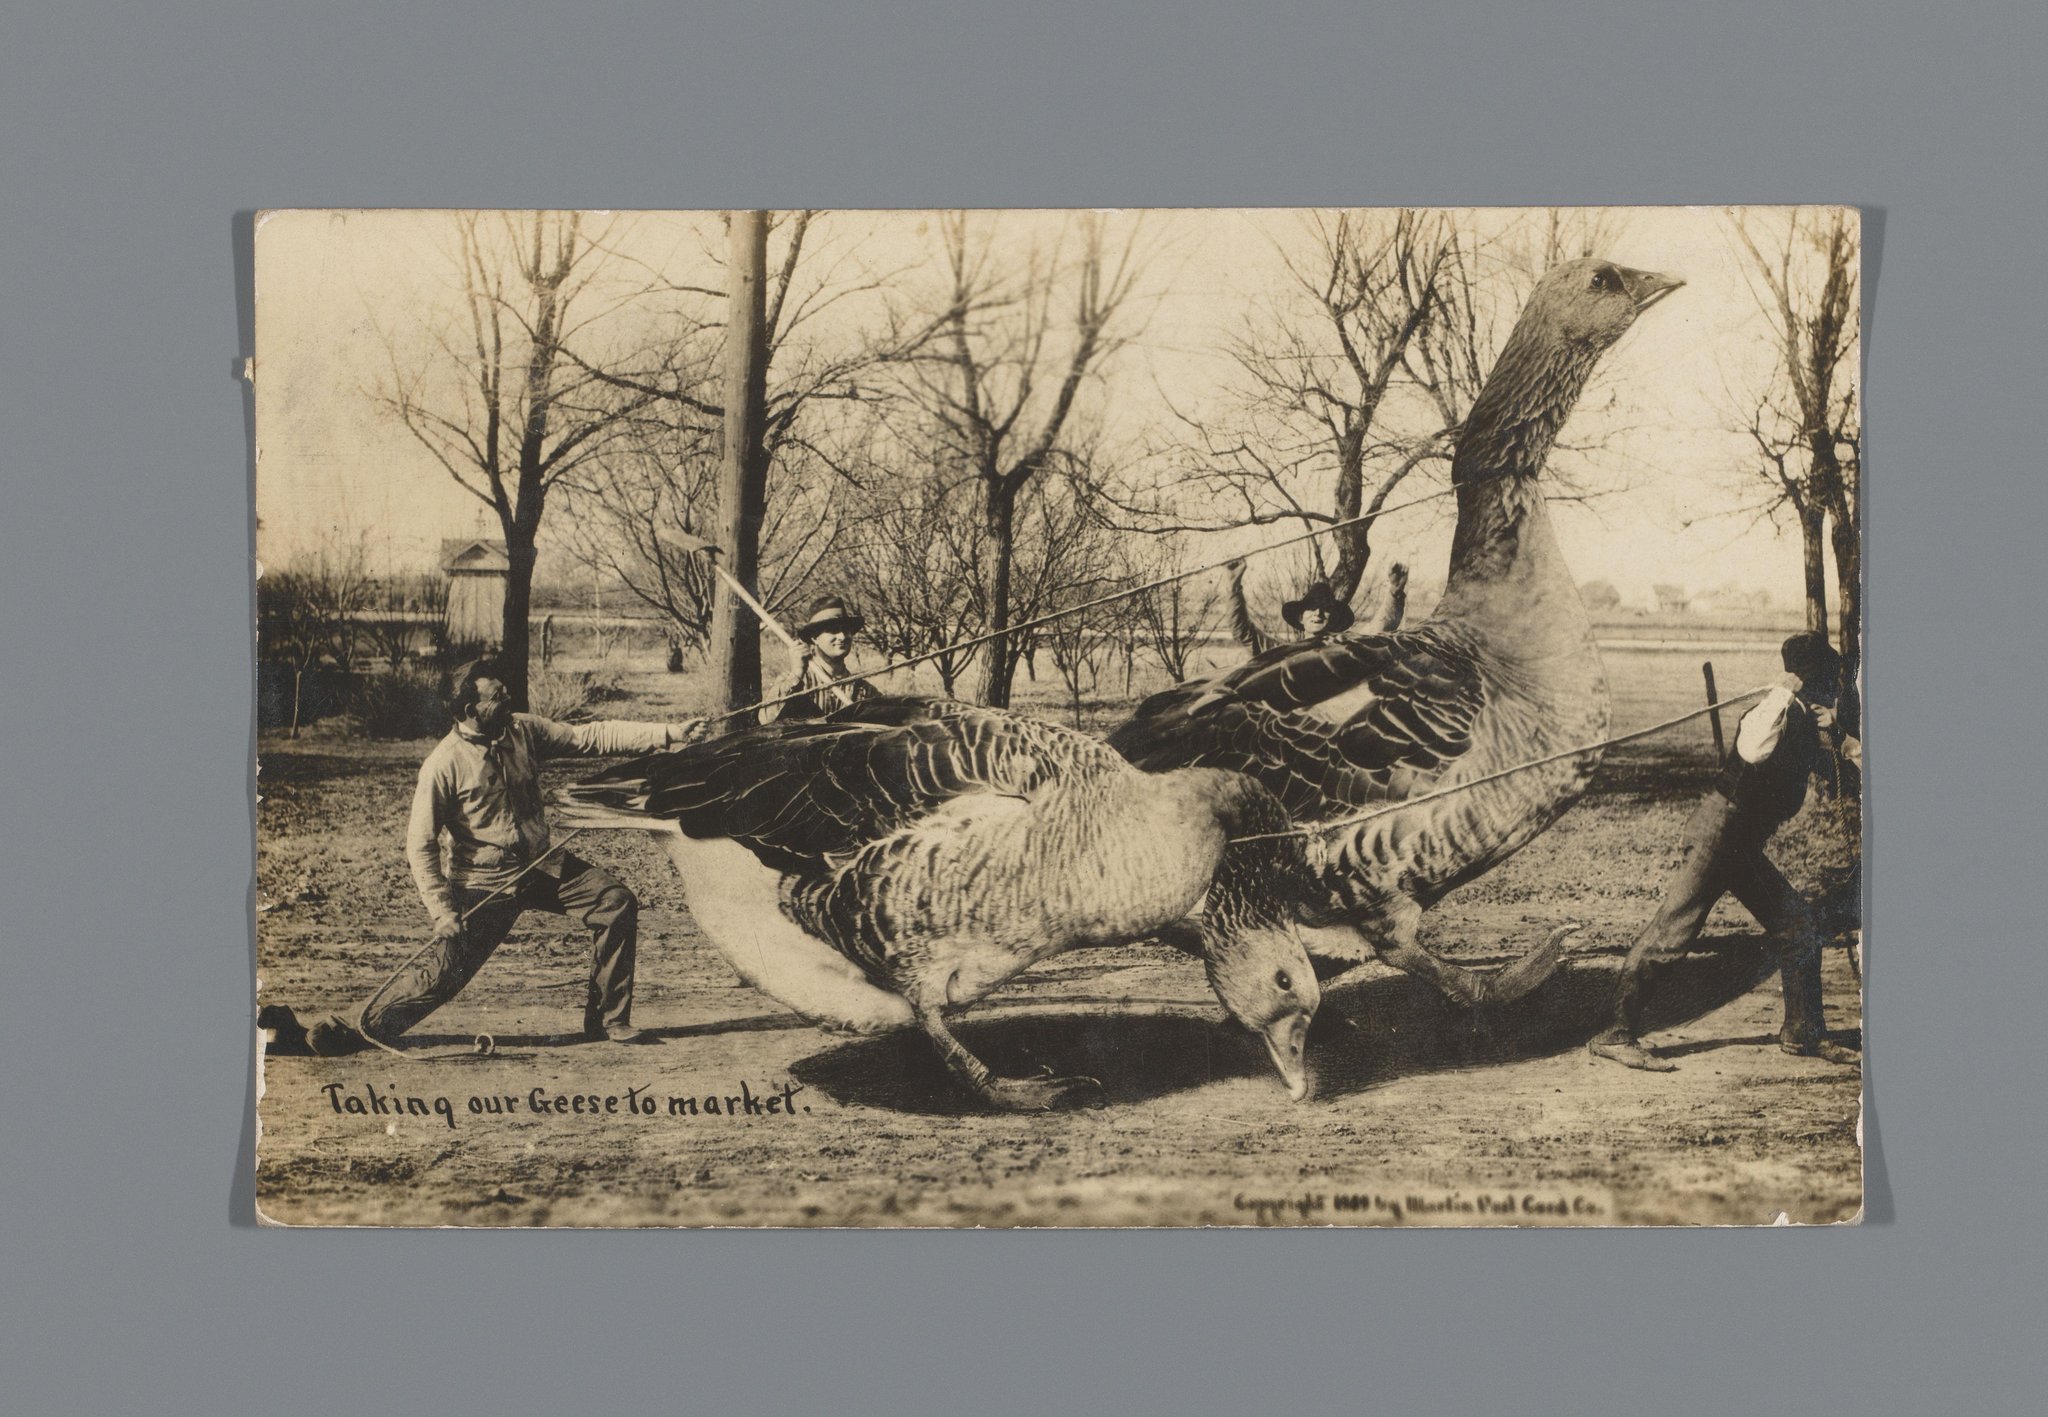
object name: photomontage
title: Taking our Geese to market (exaggeration)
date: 1909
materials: photographic support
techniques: gelatin silver print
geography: united states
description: Fotomontage van twee reusachtige ganzen die door vier mannen voortgetrokken worden